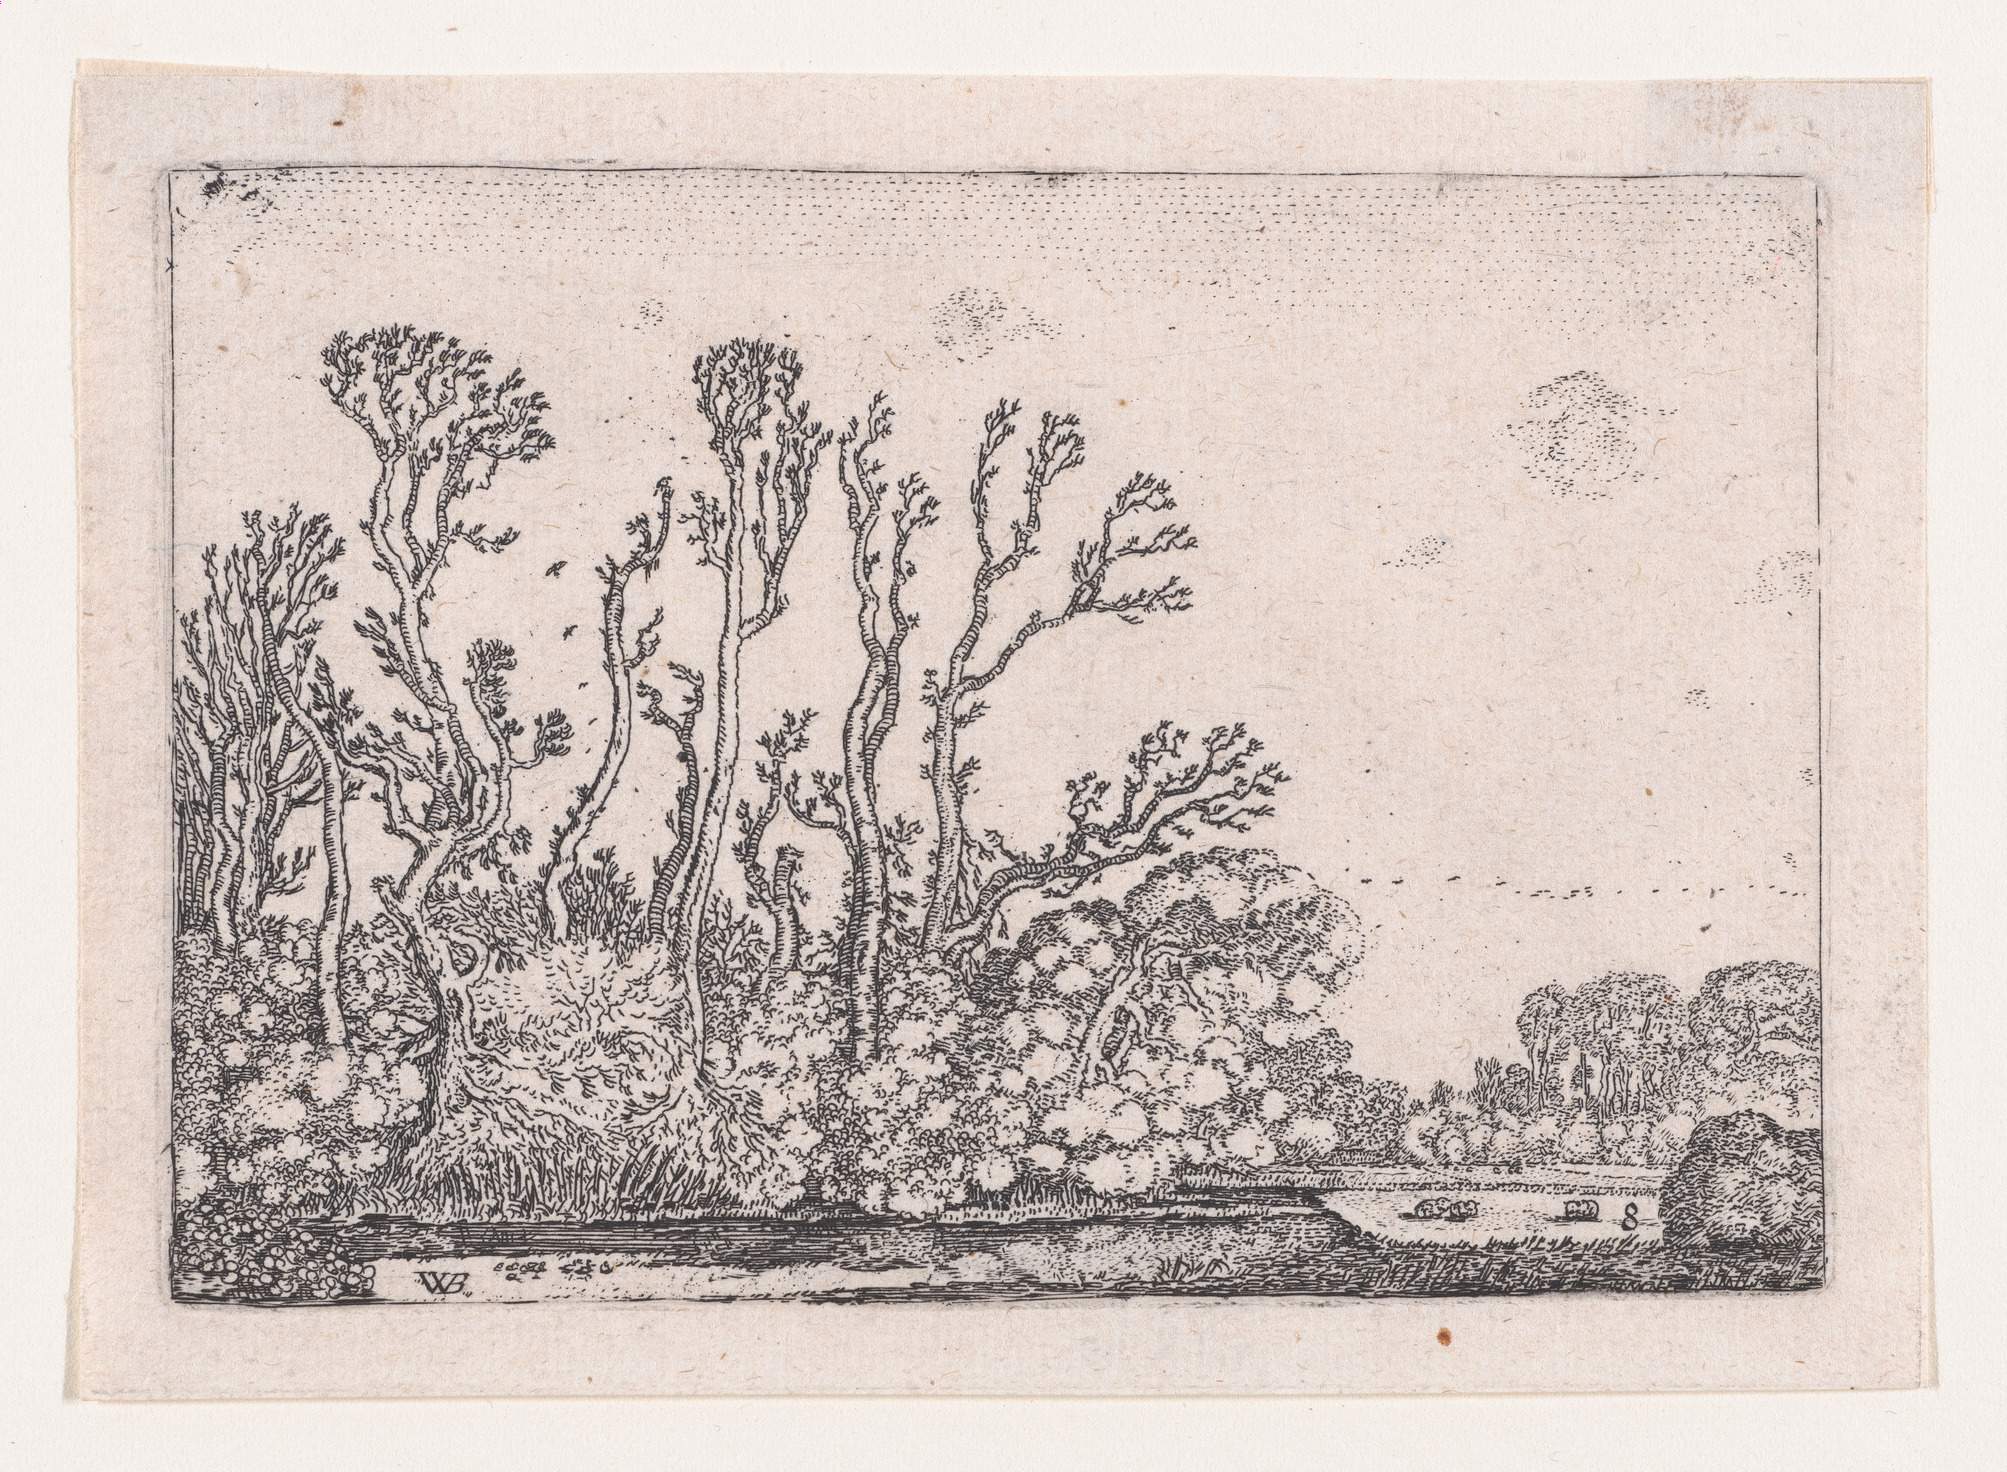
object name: print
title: Herd of Sheep Near the Water, from Verscheyden Landtschapjes (Various Little Landscapes), Plate 8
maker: willem pietersz buytewech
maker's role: artist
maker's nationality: dutch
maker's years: 1591-1624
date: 1616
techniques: etching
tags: landscapes,trees